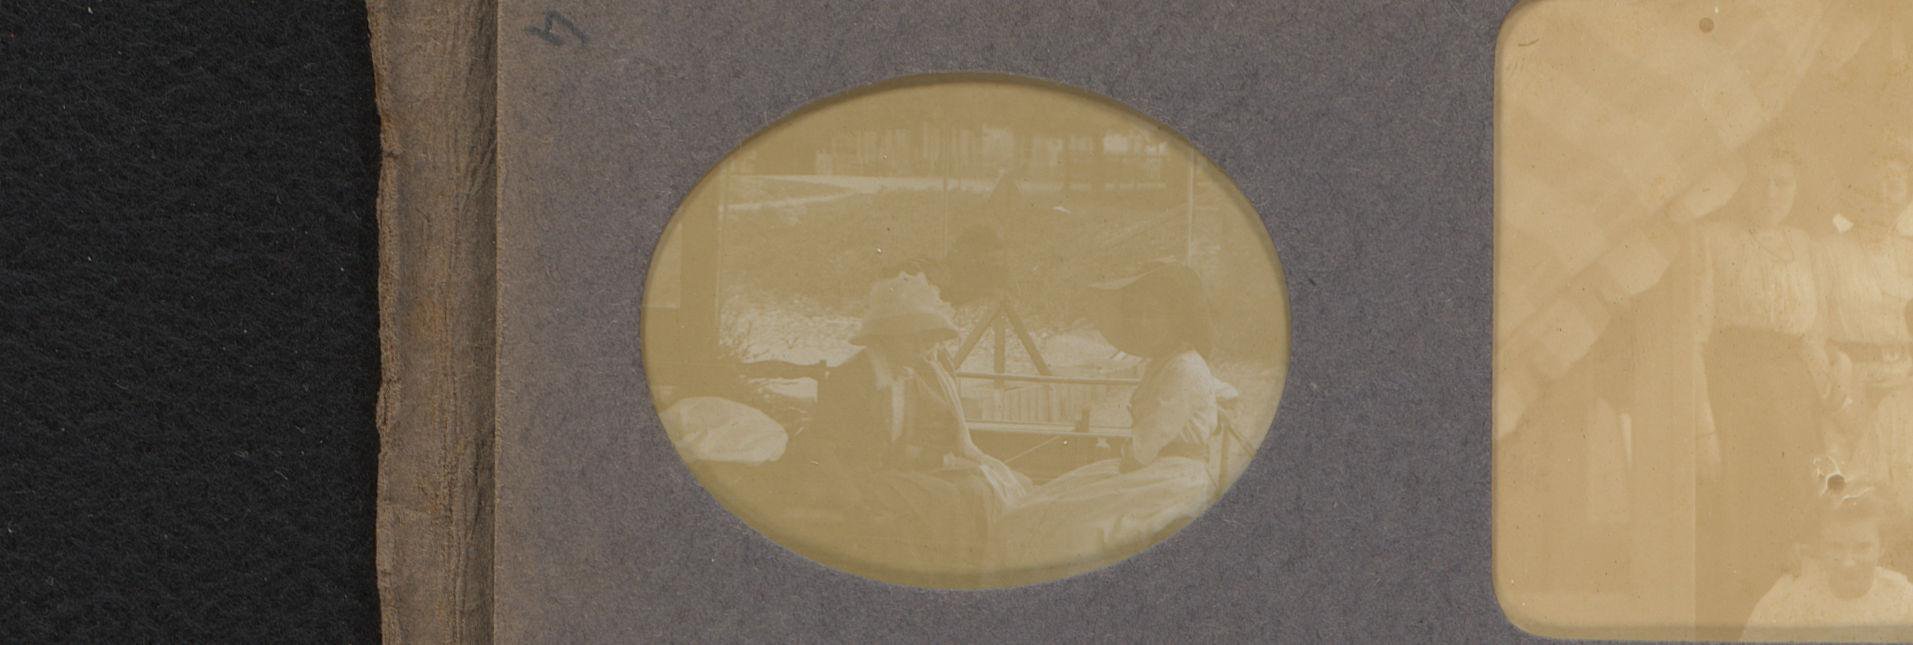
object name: album leaf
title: Jenny Wichers en Pauline van den Bussche op een veranda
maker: Anonymous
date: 1910-1911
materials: paper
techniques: gelatin silver print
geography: gelderland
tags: the hague, sculptor, jenny cornelia henriette wichers (jane), adolescent, young woman, maiden, gelderland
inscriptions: inscription: ‘Pauline Jenny’